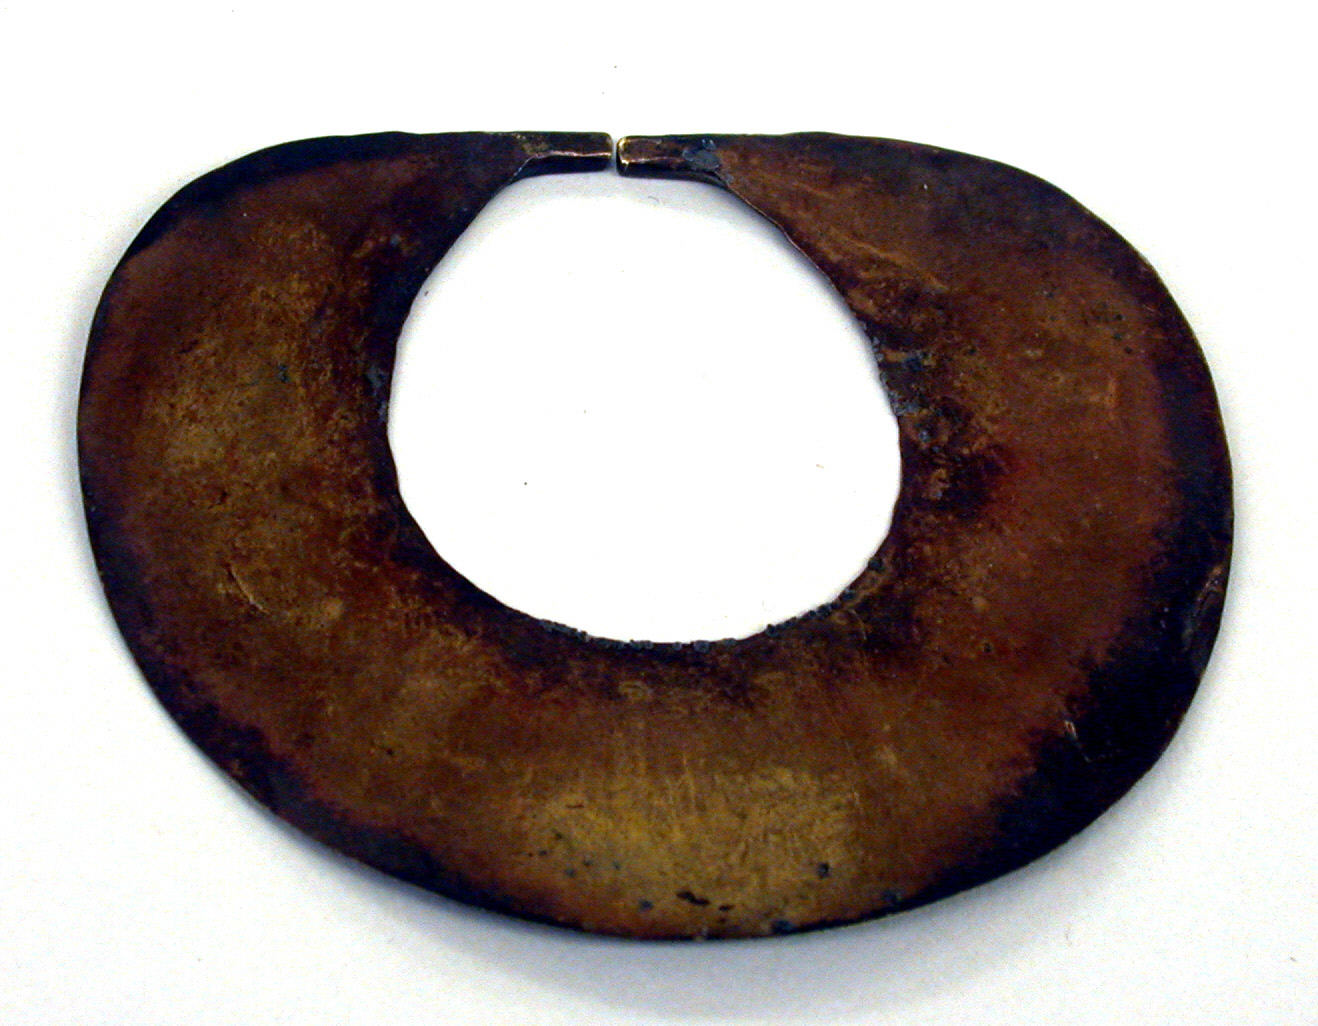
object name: nose ornament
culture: moche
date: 501-700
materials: gold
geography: peru